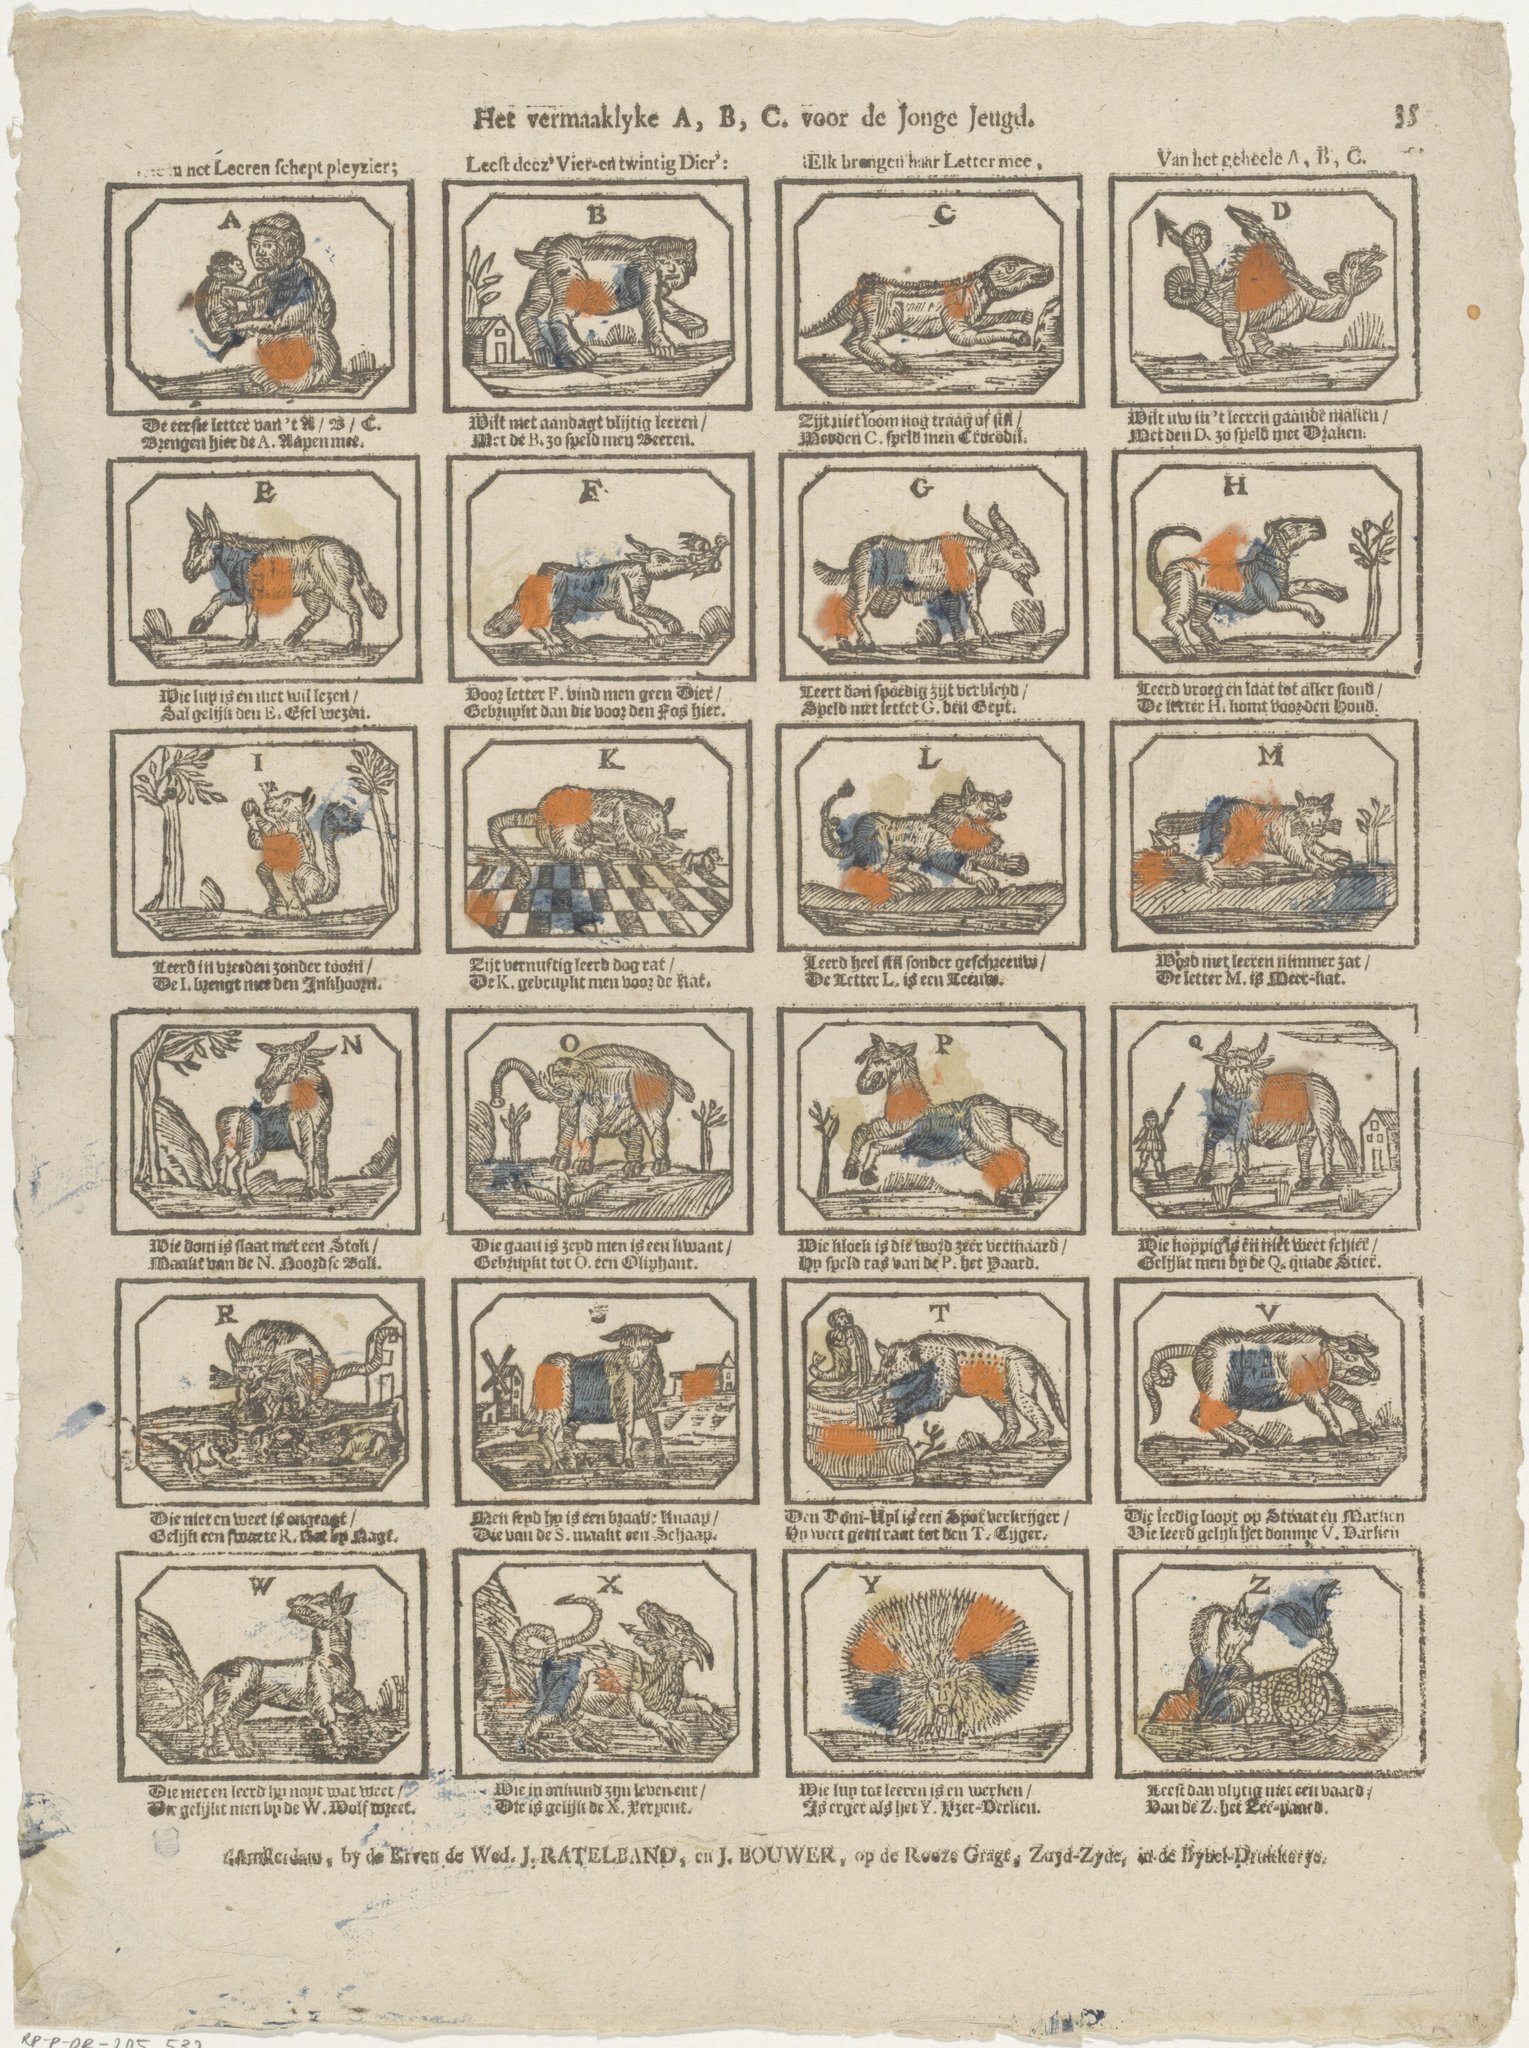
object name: popular print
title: Het vermaaklyke A,B,C. voor de jonge jeugd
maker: Anonymous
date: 1782-1793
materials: paper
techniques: colour, letterpress printing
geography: amsterdam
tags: animals, letters, alphabet, script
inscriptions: collector's mark: Lugt 2760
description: Blad 24 voorstellingen van de letters van het alfabet geïllustreerd met dieren waarvan de namen met de betreffende letter beginnen. Onder elke voorstelling een tweeregelig vers. Genummerd rechtsboven: 35.